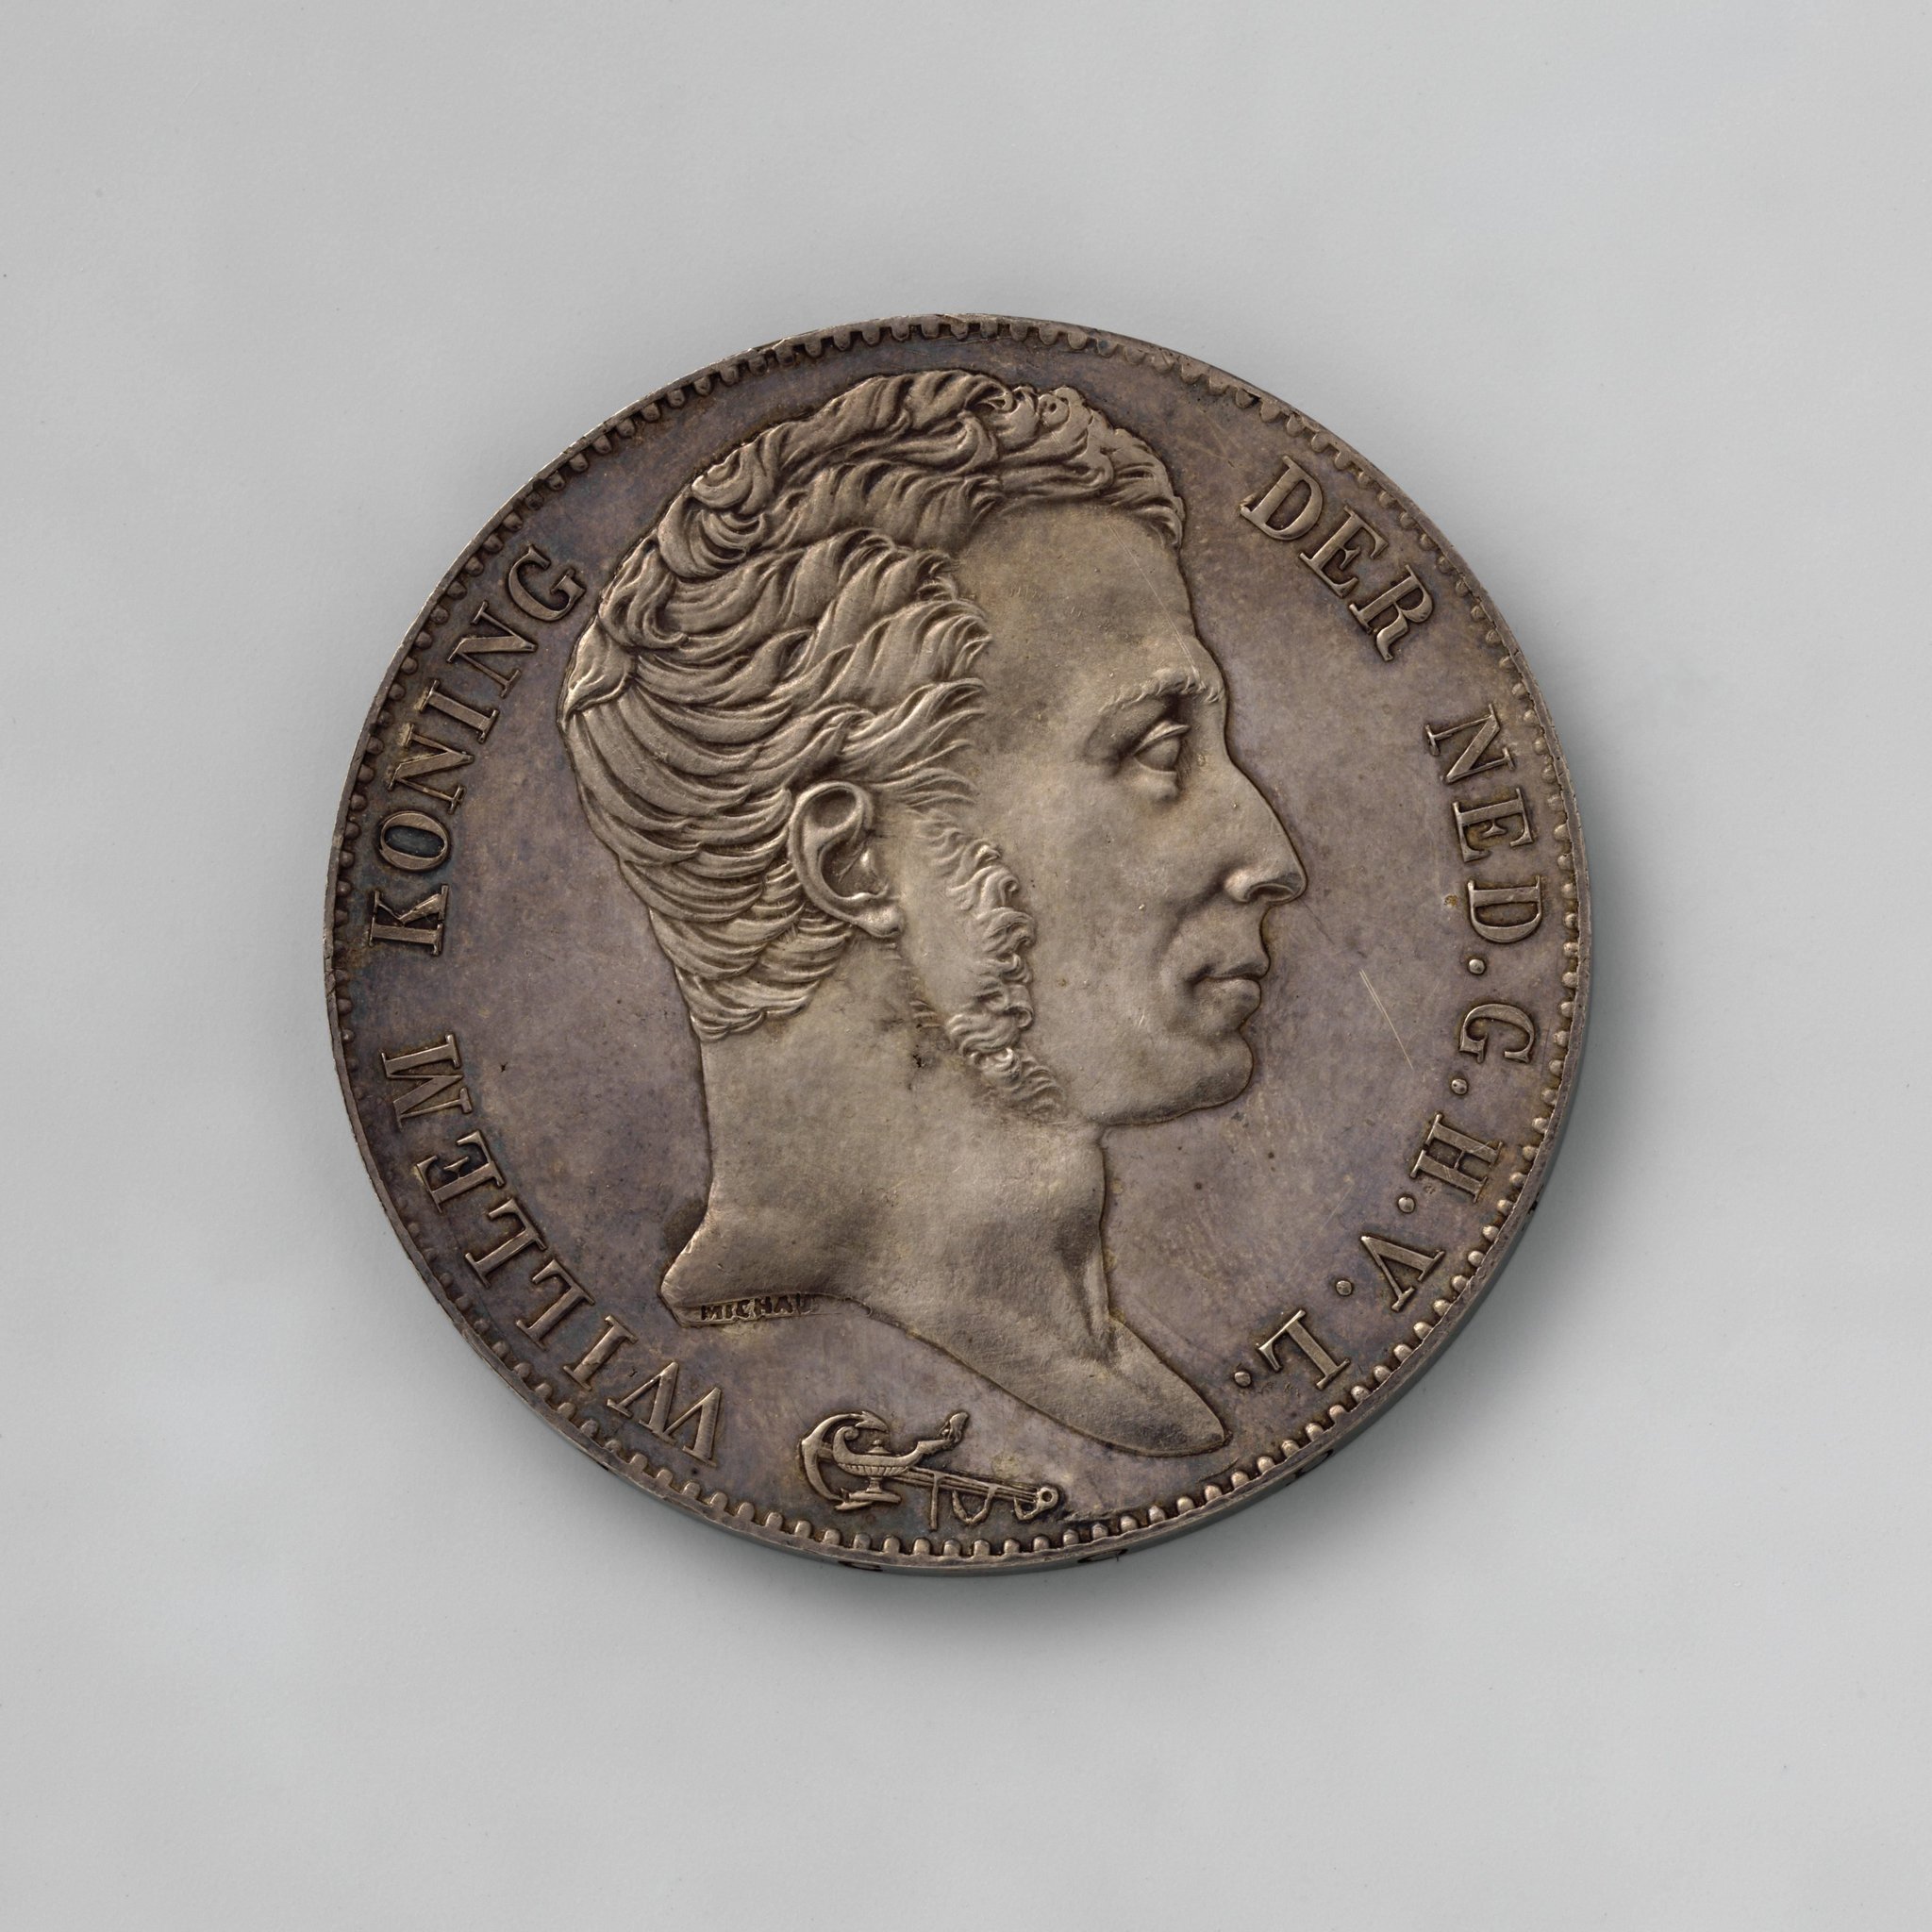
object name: coin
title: Nederland, 3 gulden, 1819 Utrecht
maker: william i of the netherlands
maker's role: koning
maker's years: 1772-1843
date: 1819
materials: silver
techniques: striking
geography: utrecht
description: Zilveren munt. Voorzijde: borstbeeld naar rechts. Keerzijde: tussen waarde-aanduiding 3 G gekroond rijkswapenschild. Jaartal boven kroon. Randschrift.